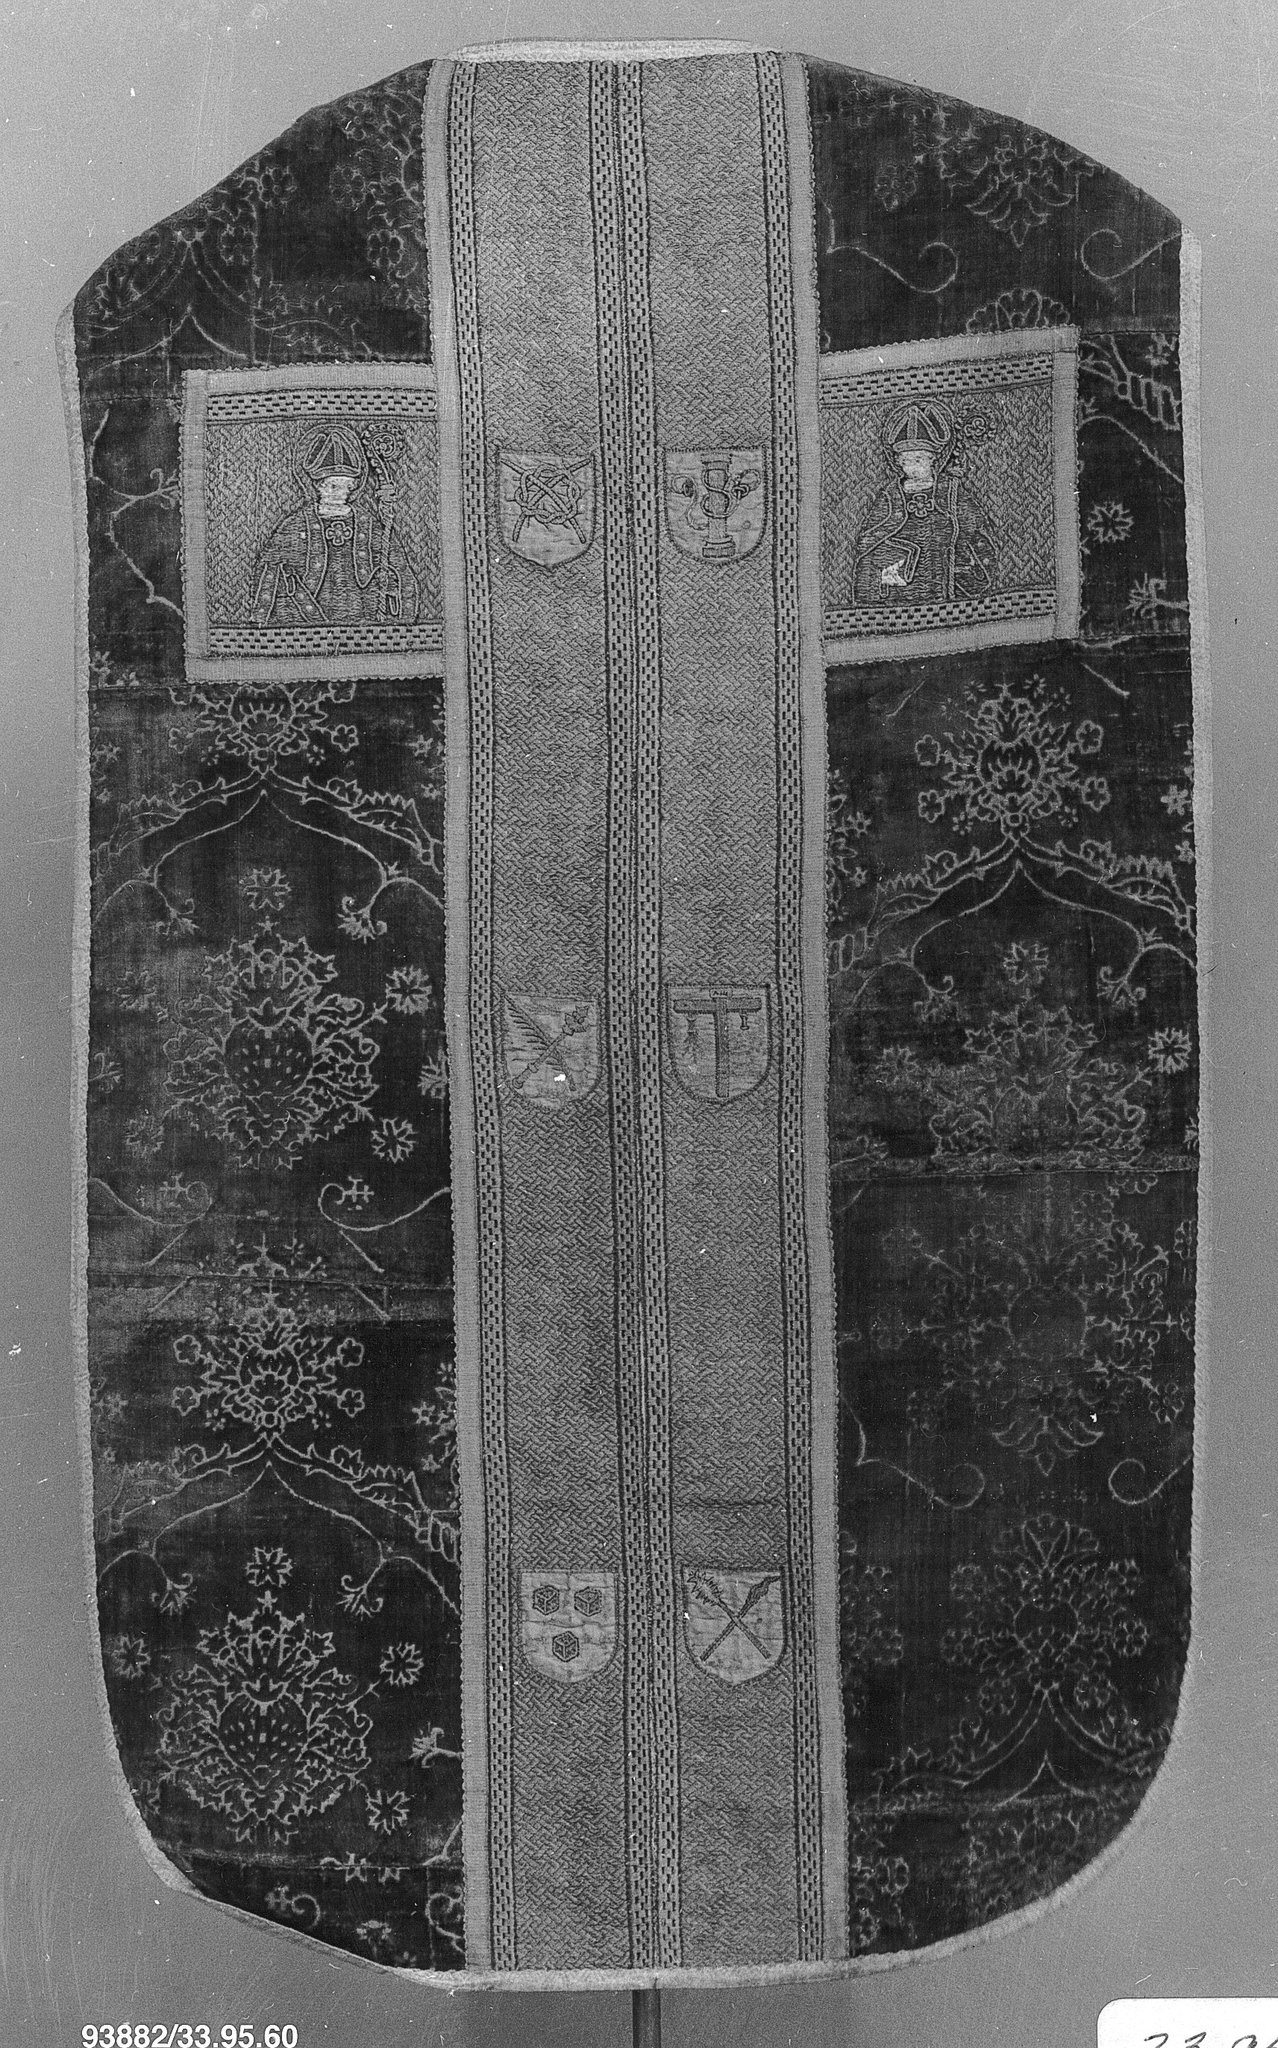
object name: chasuble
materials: metal thread, silk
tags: men,flowers,cross